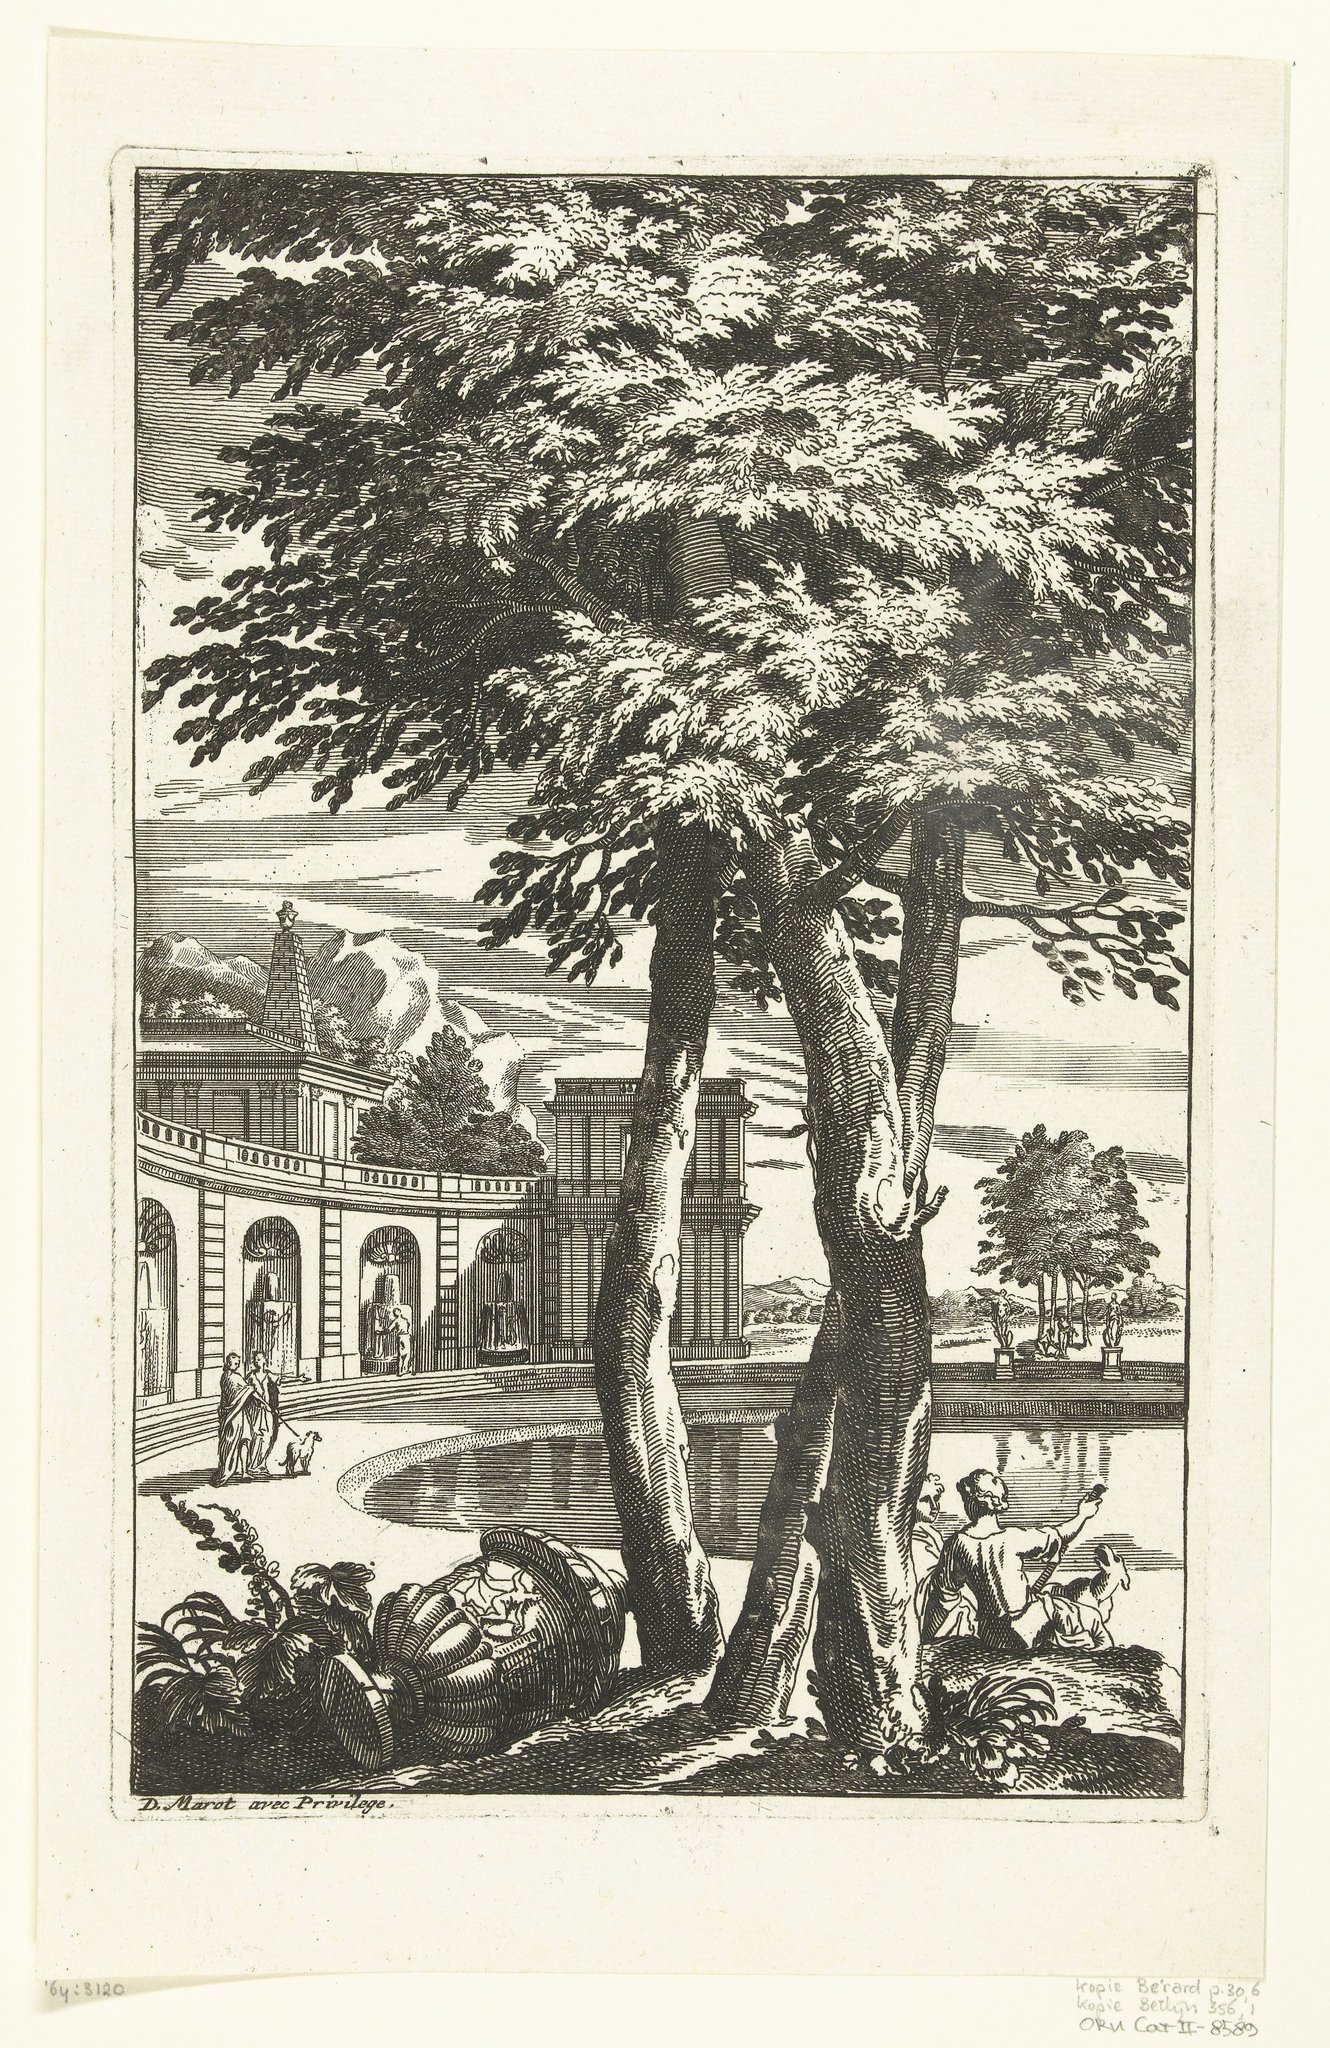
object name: print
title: Nouveaux Lieure de Paysages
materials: paper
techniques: etching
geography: netherlands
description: Achter de bomen bevindt zich een ronde vijver met een muur met nissen en cascades. Tegenzijdige kopie naar blad uit serie Nouveau liure de paysages. Uit serie van 6 bladen.